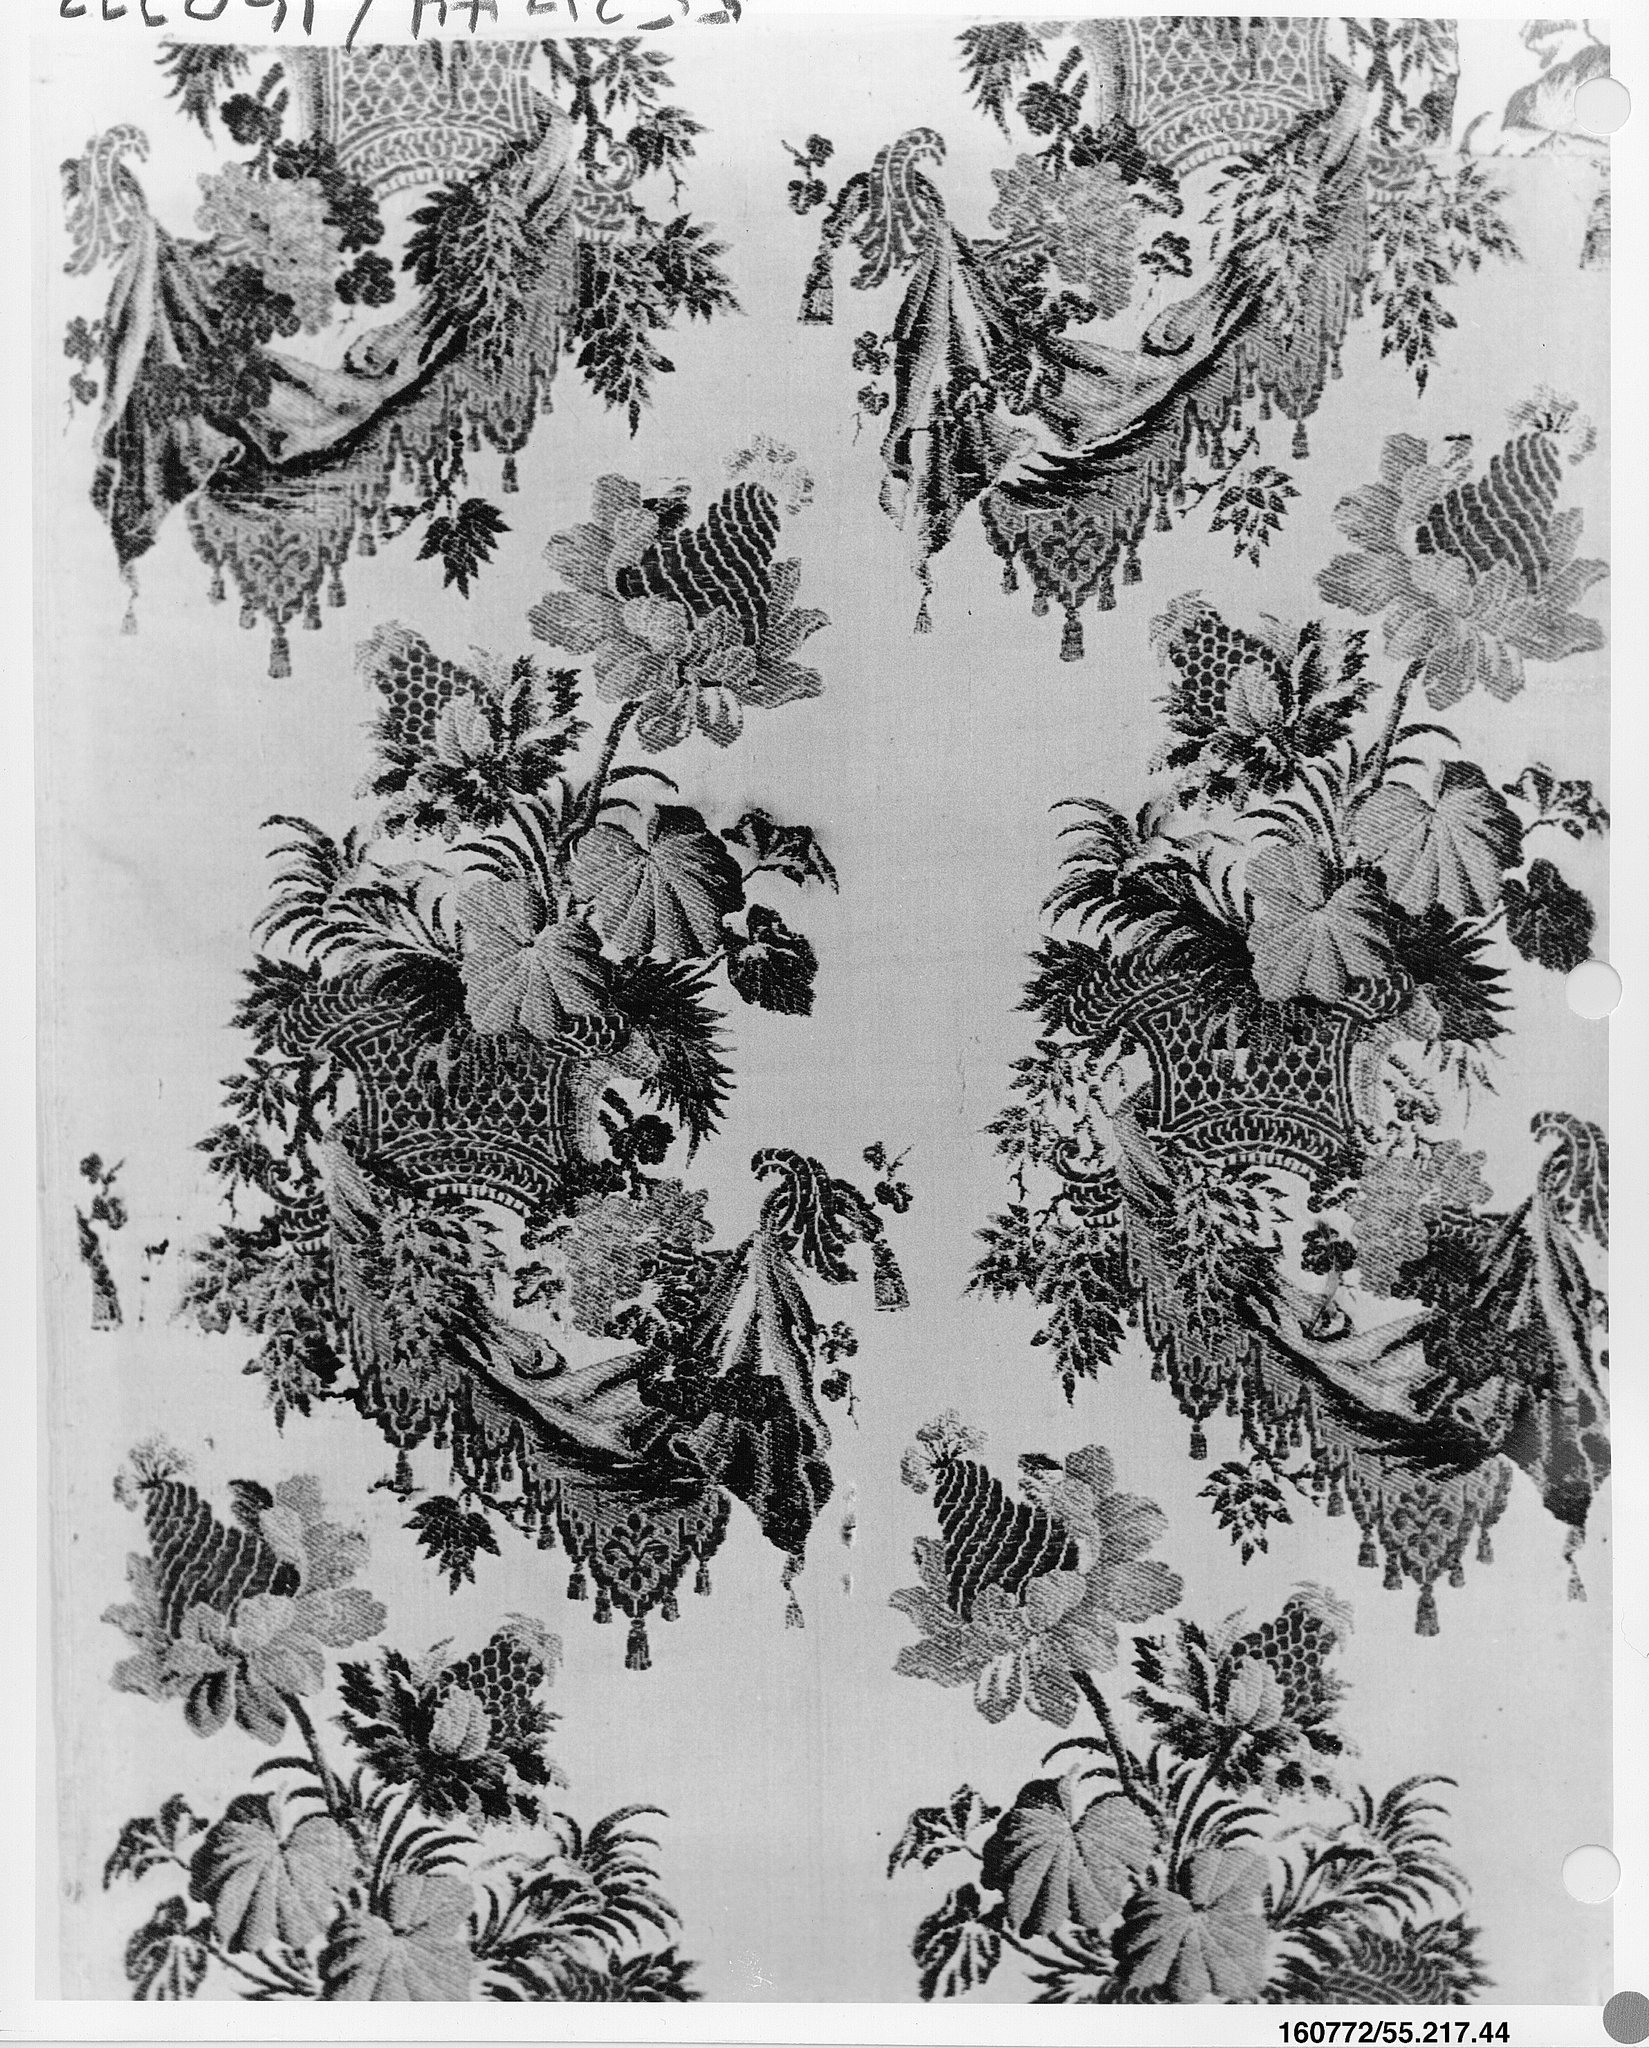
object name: piece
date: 1735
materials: metal thread, silk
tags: flowers,leaves